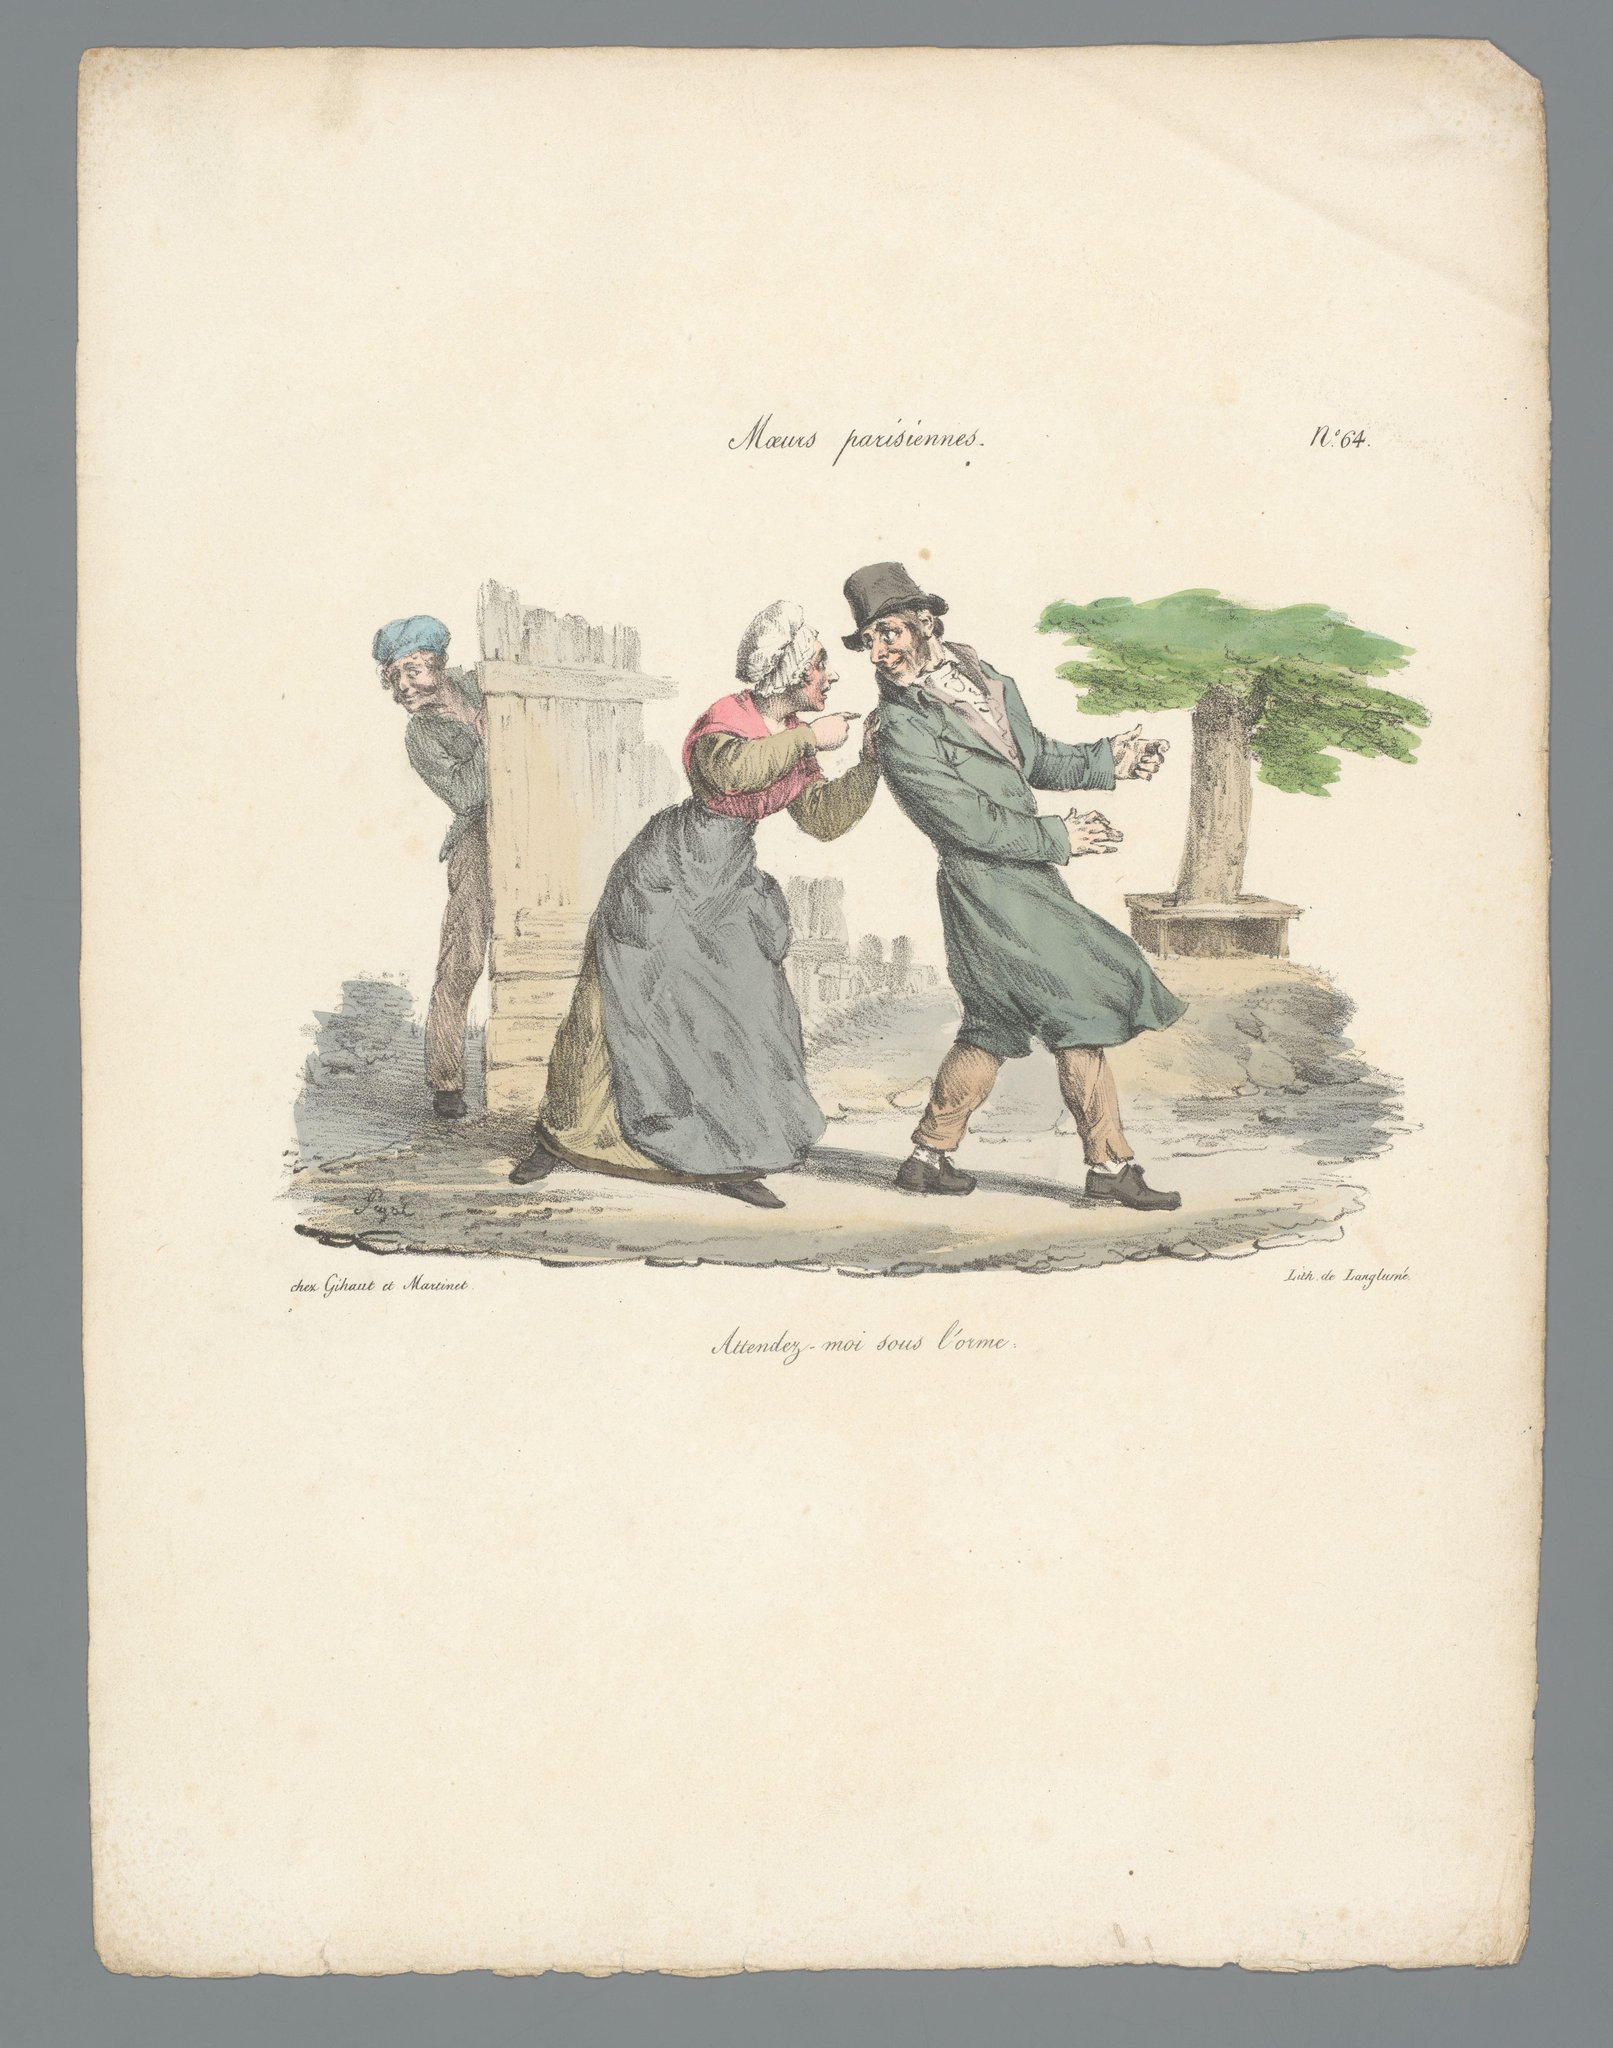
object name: print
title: Attendez-moi sous l'orme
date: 1825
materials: paper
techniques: hand coloring, lithograph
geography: paris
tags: fence, wall, paling, adult woman (+ two persons)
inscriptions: collector's mark: Lugt 2228